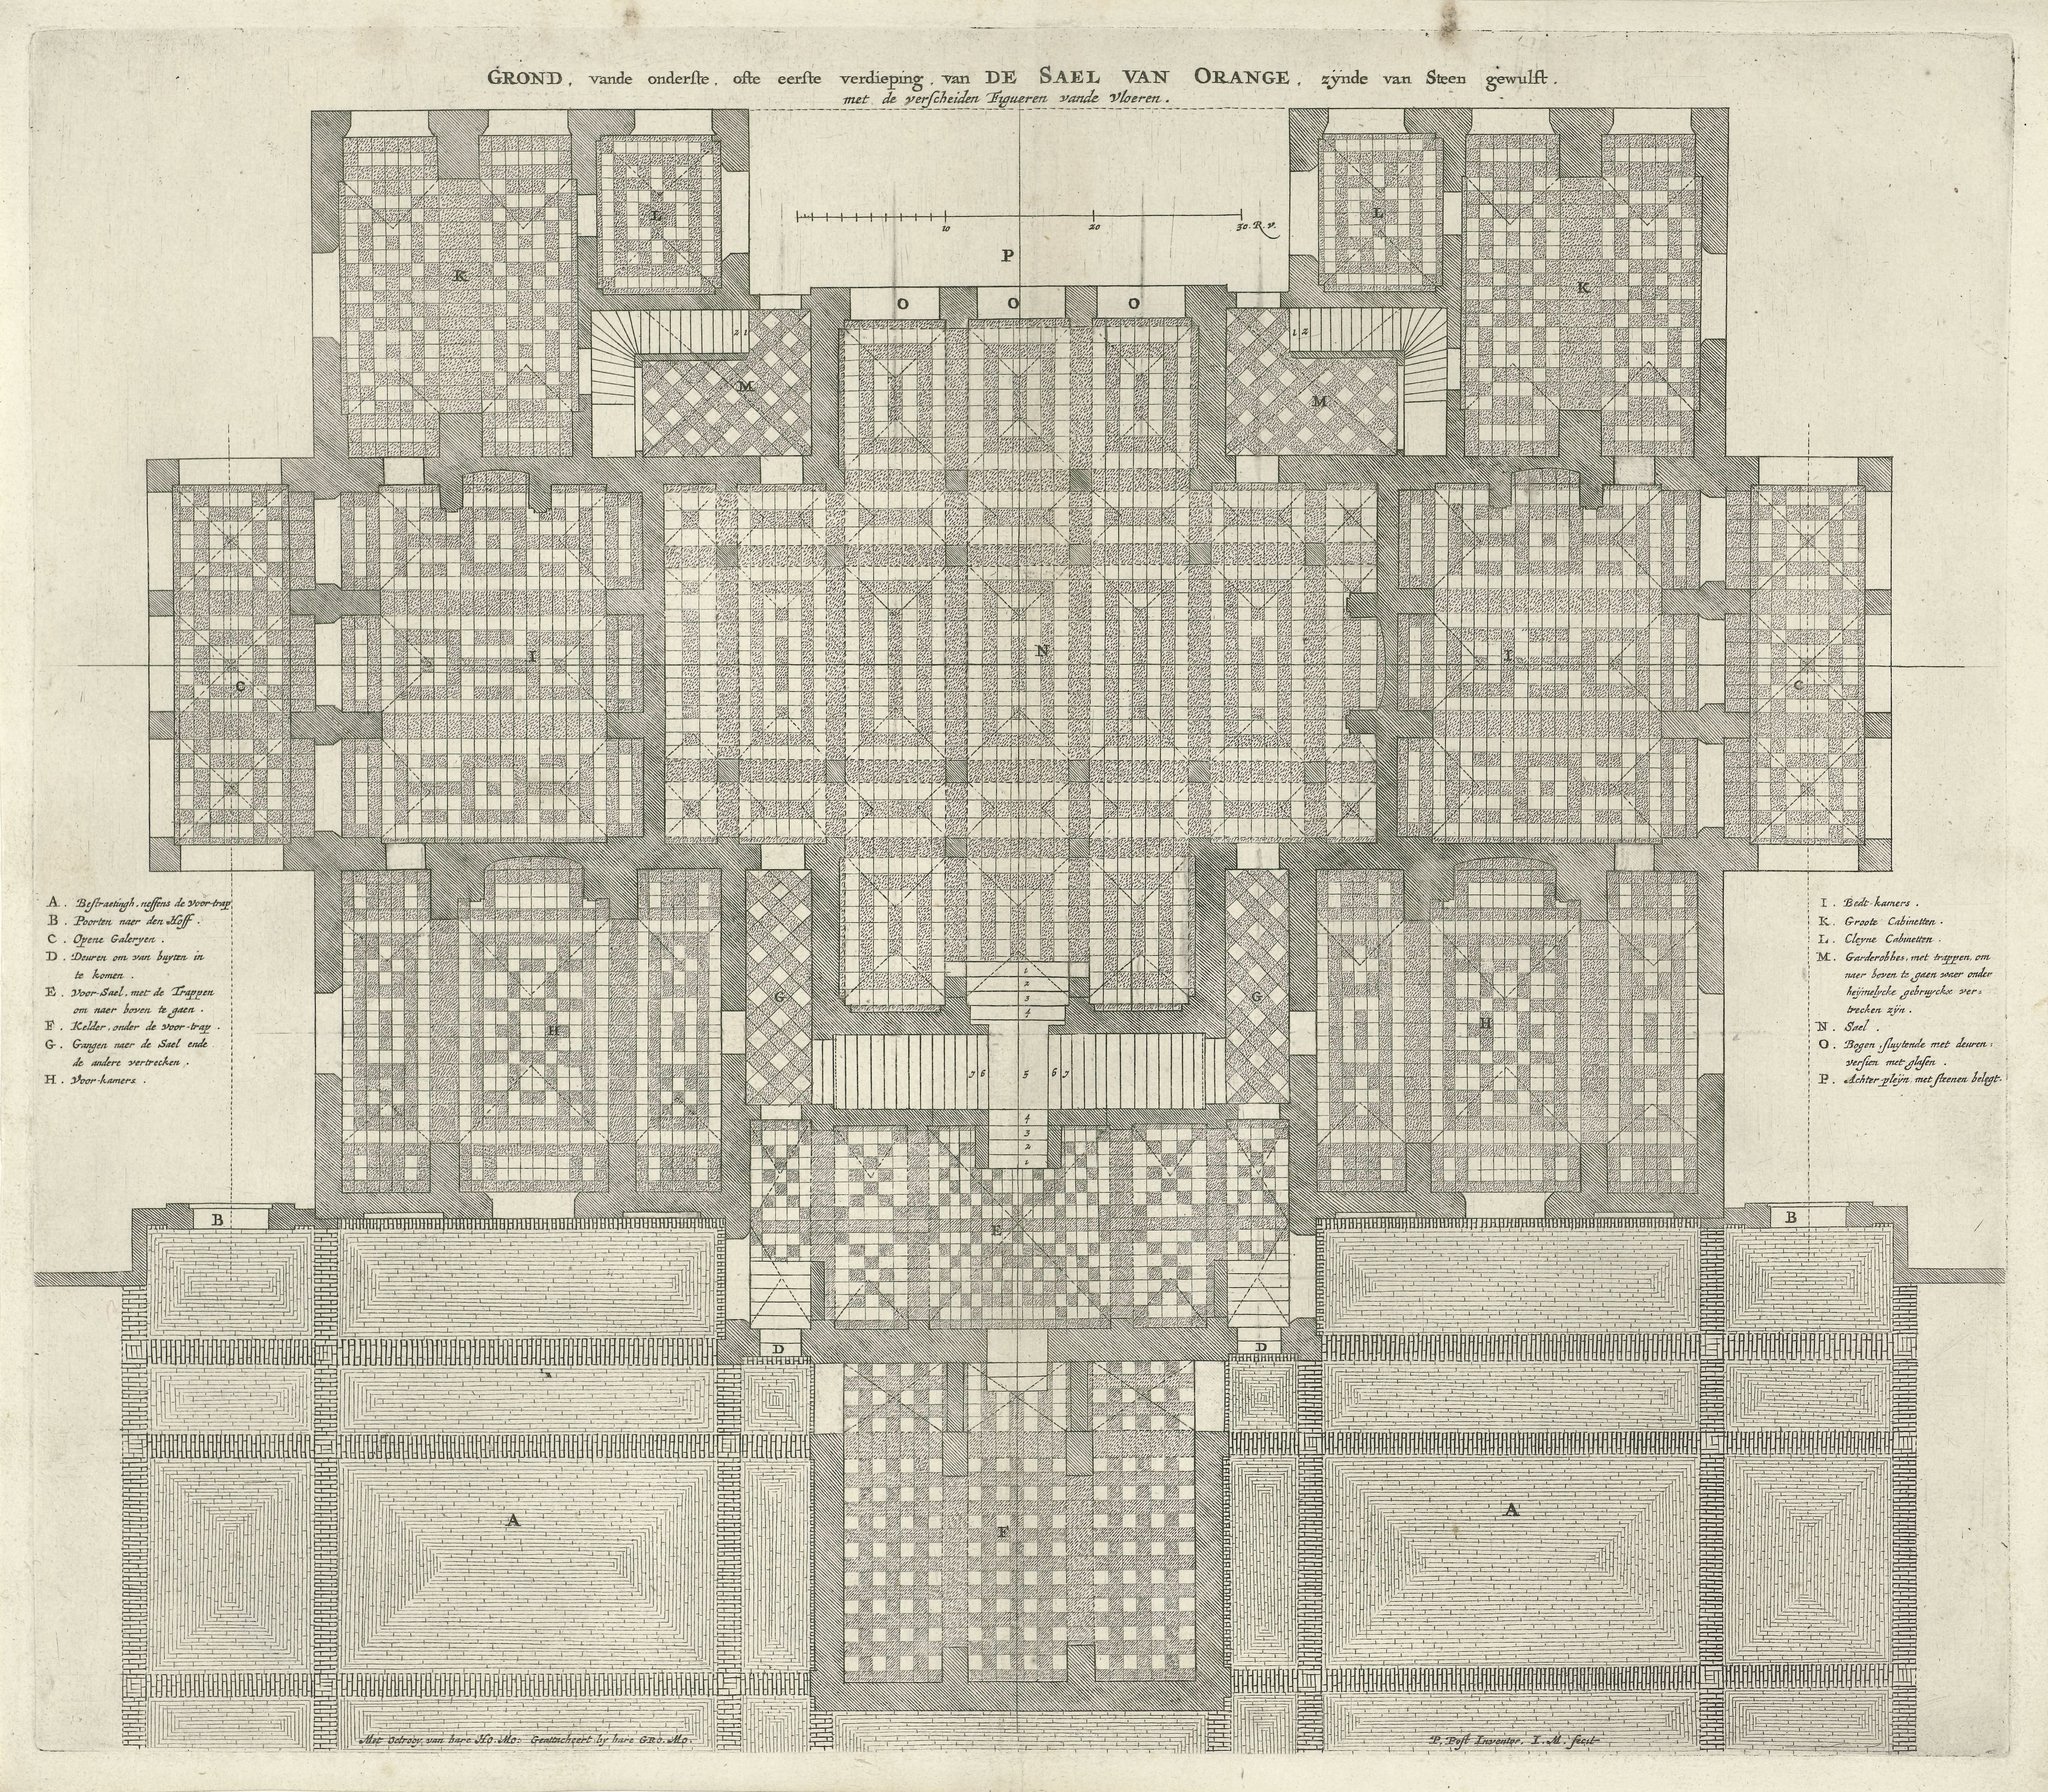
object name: print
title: Groundplan of the First Floor of the Palace Huis ten Bosch showing the Floor Decorations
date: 1655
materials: paper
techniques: etching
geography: amsterdam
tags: palace, plan ~ architecture, pavement, floor ~ architecture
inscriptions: collector's mark: Lugt 2228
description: Souterrain van Paleis Huis ten Bosch te Den Haag met de vloerpatronen. Links en rechts een legenda.